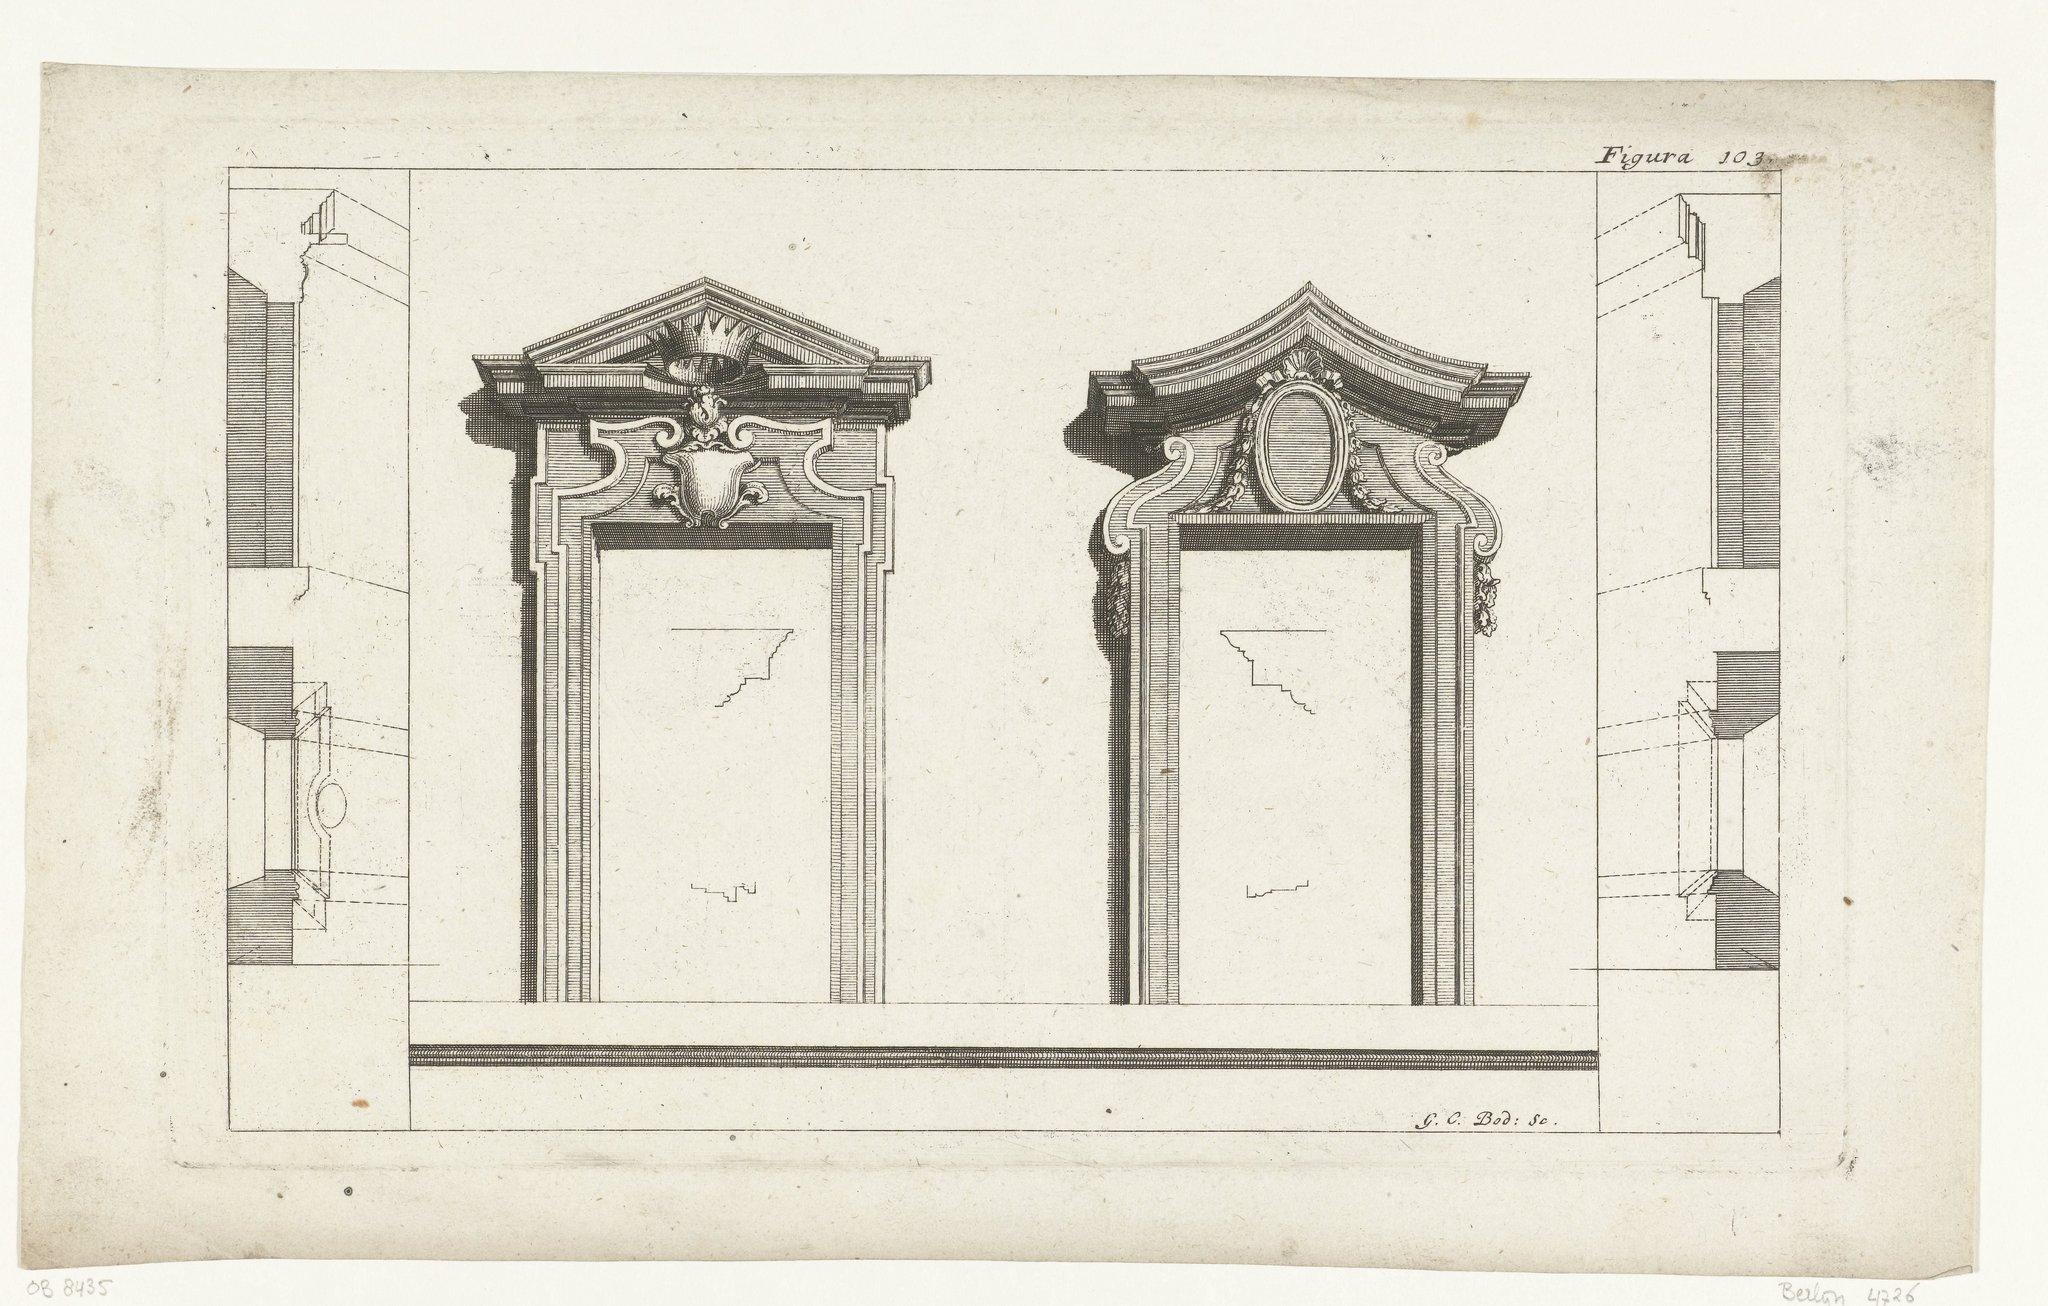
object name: ornament print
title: Perspectivae Pictorum atque Architectorum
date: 1708-1711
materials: paper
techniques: engraving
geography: germany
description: Raamkozijnen met opstand, plan, profiel en details. Rechtsboven staat: Figura 103.